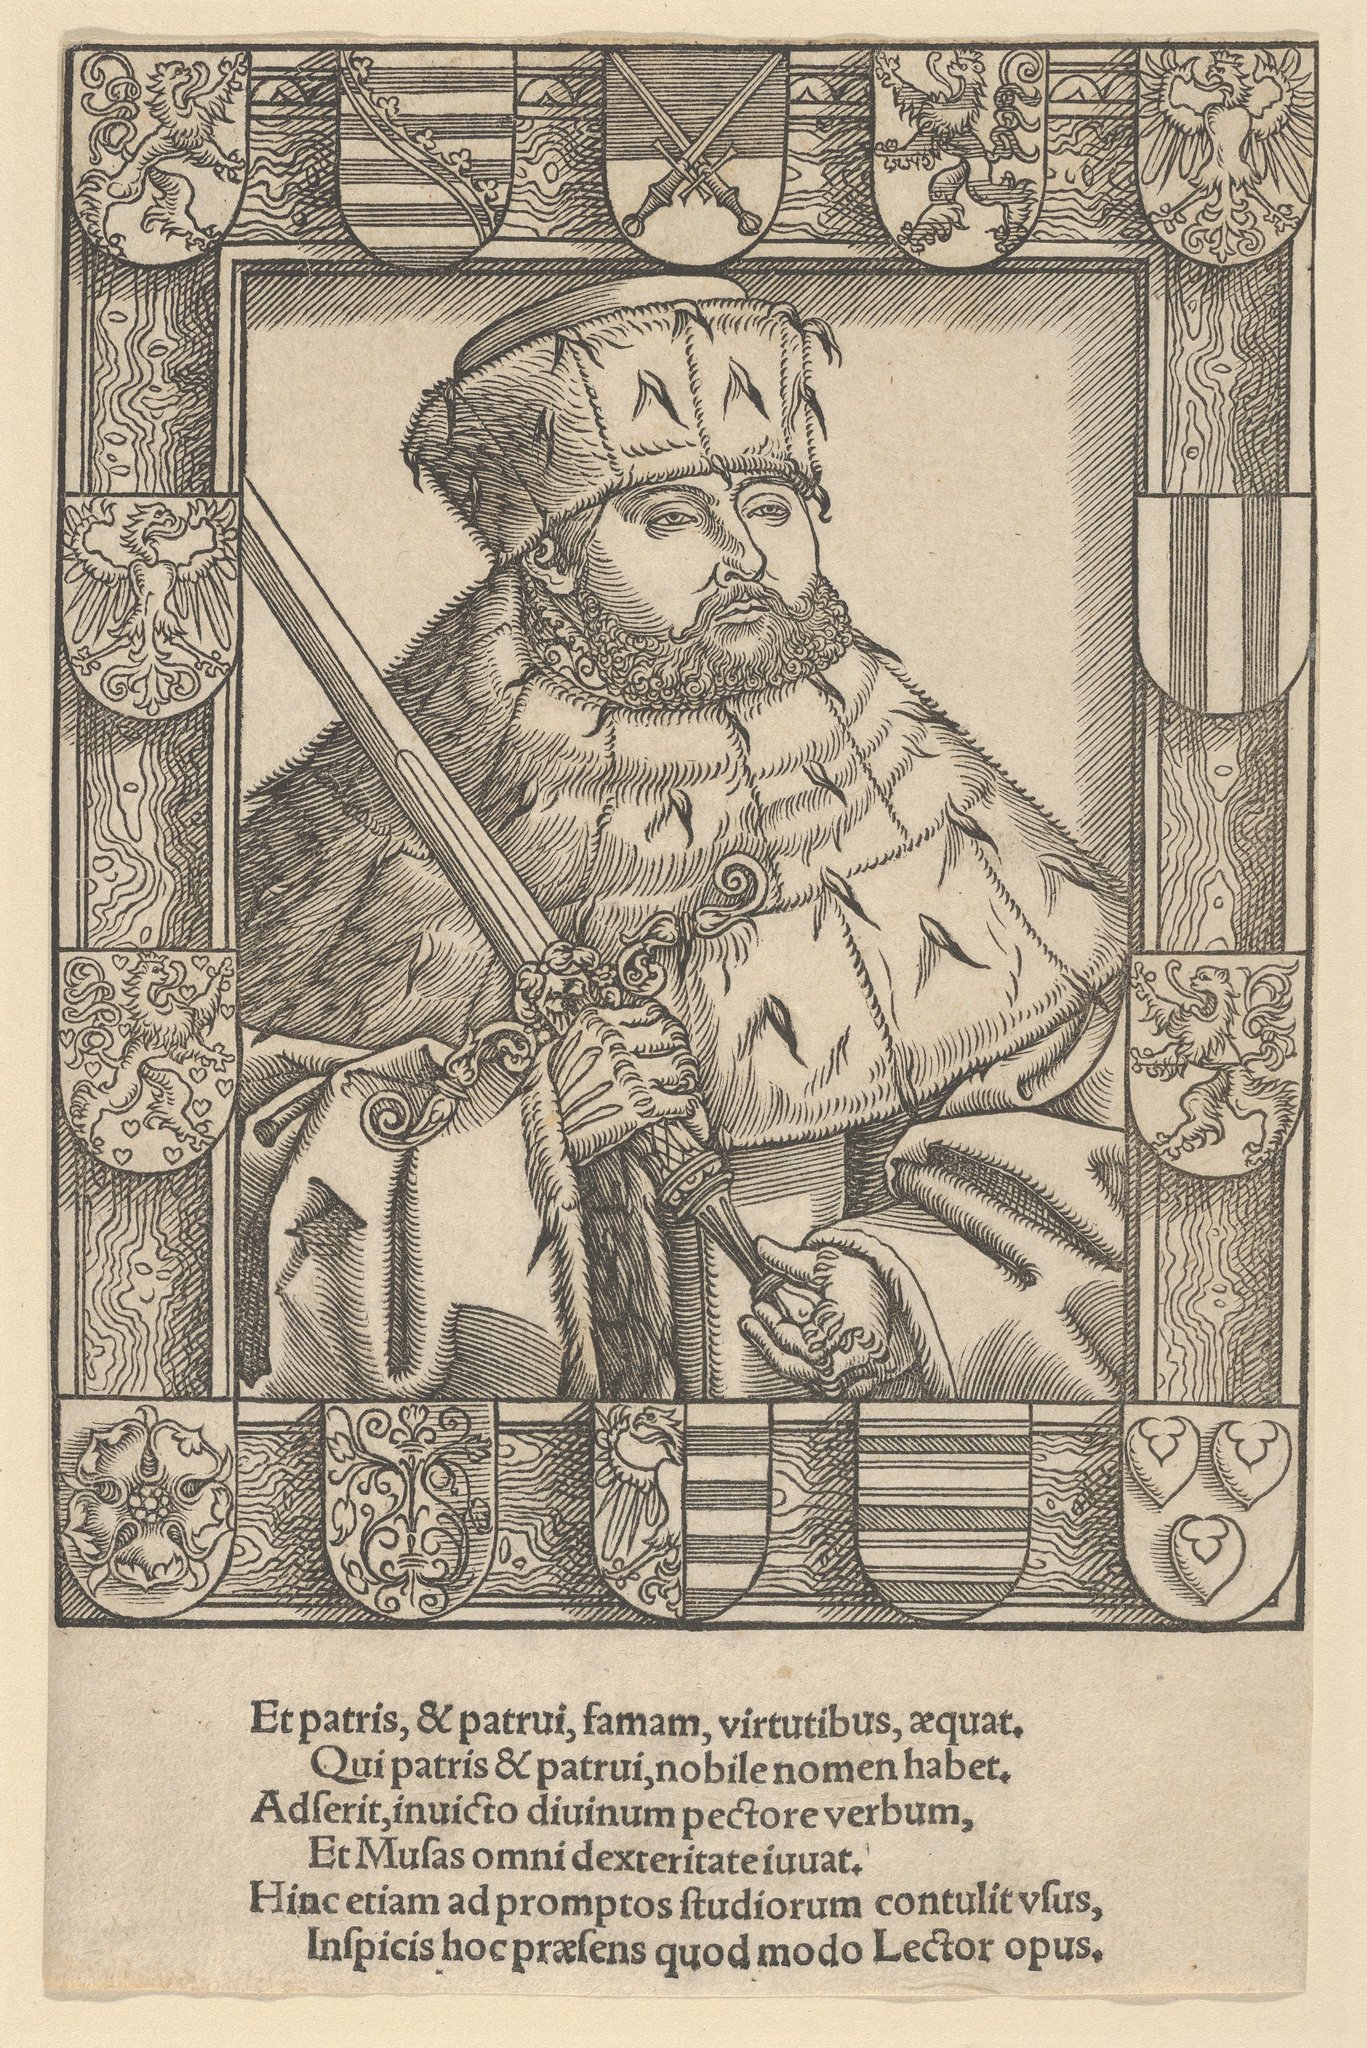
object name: print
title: Copy of John Frederic the Magnanimous, in Electoral Robes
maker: lucas cranach the younger and workshop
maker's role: artist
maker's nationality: german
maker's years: 1515-1586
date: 1515-1586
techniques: woodcut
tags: men,portraits,coat of arms